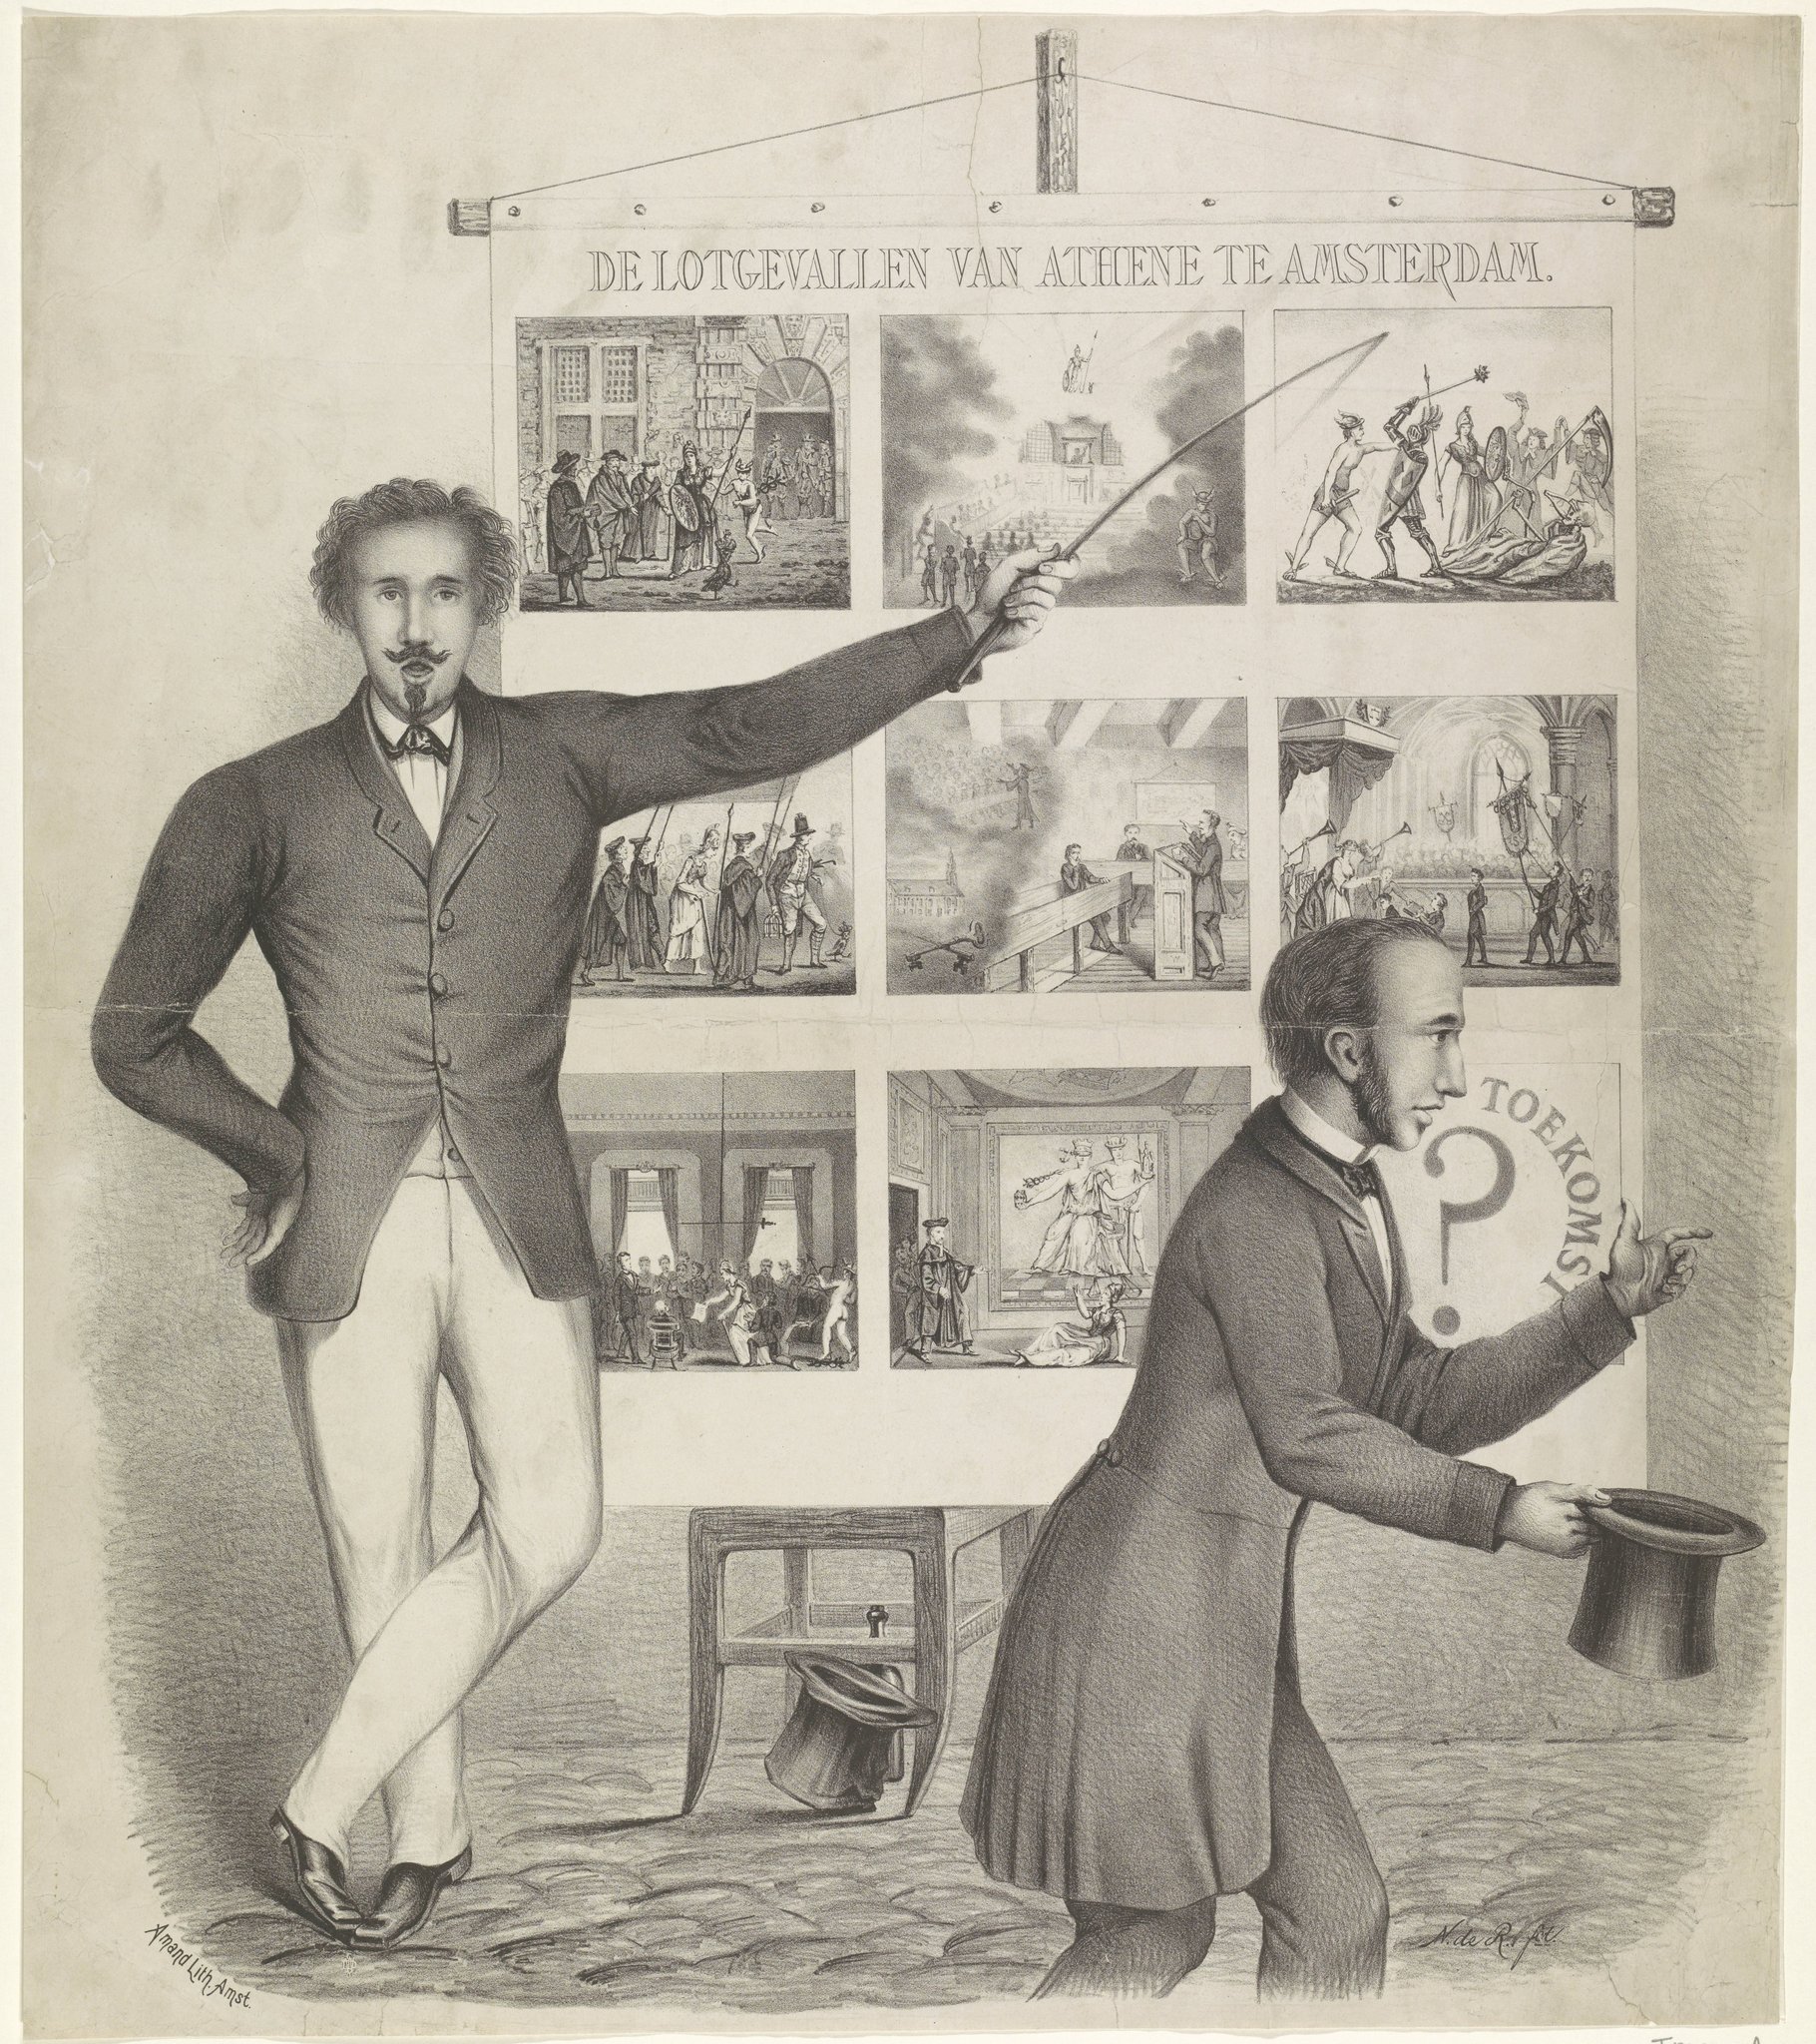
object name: cartoon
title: De lotgevallen van Athene te Amsterdam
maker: nicolaas de roever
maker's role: draughtsman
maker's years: 1850-1894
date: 1875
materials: paper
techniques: lithograph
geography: amsterdam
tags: university, amsterdam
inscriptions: collector's mark: Lugt 2228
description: Illustratie uit de studentenalmanak van de Universiteit van Amsterdam van het jaar 1875. Spotprent op de vaak voorgestelde vervanging van het Athenaeum Illustre door een Gemeentelijke Hogeschool. Een student wijst scènes aan op een wandplaat.